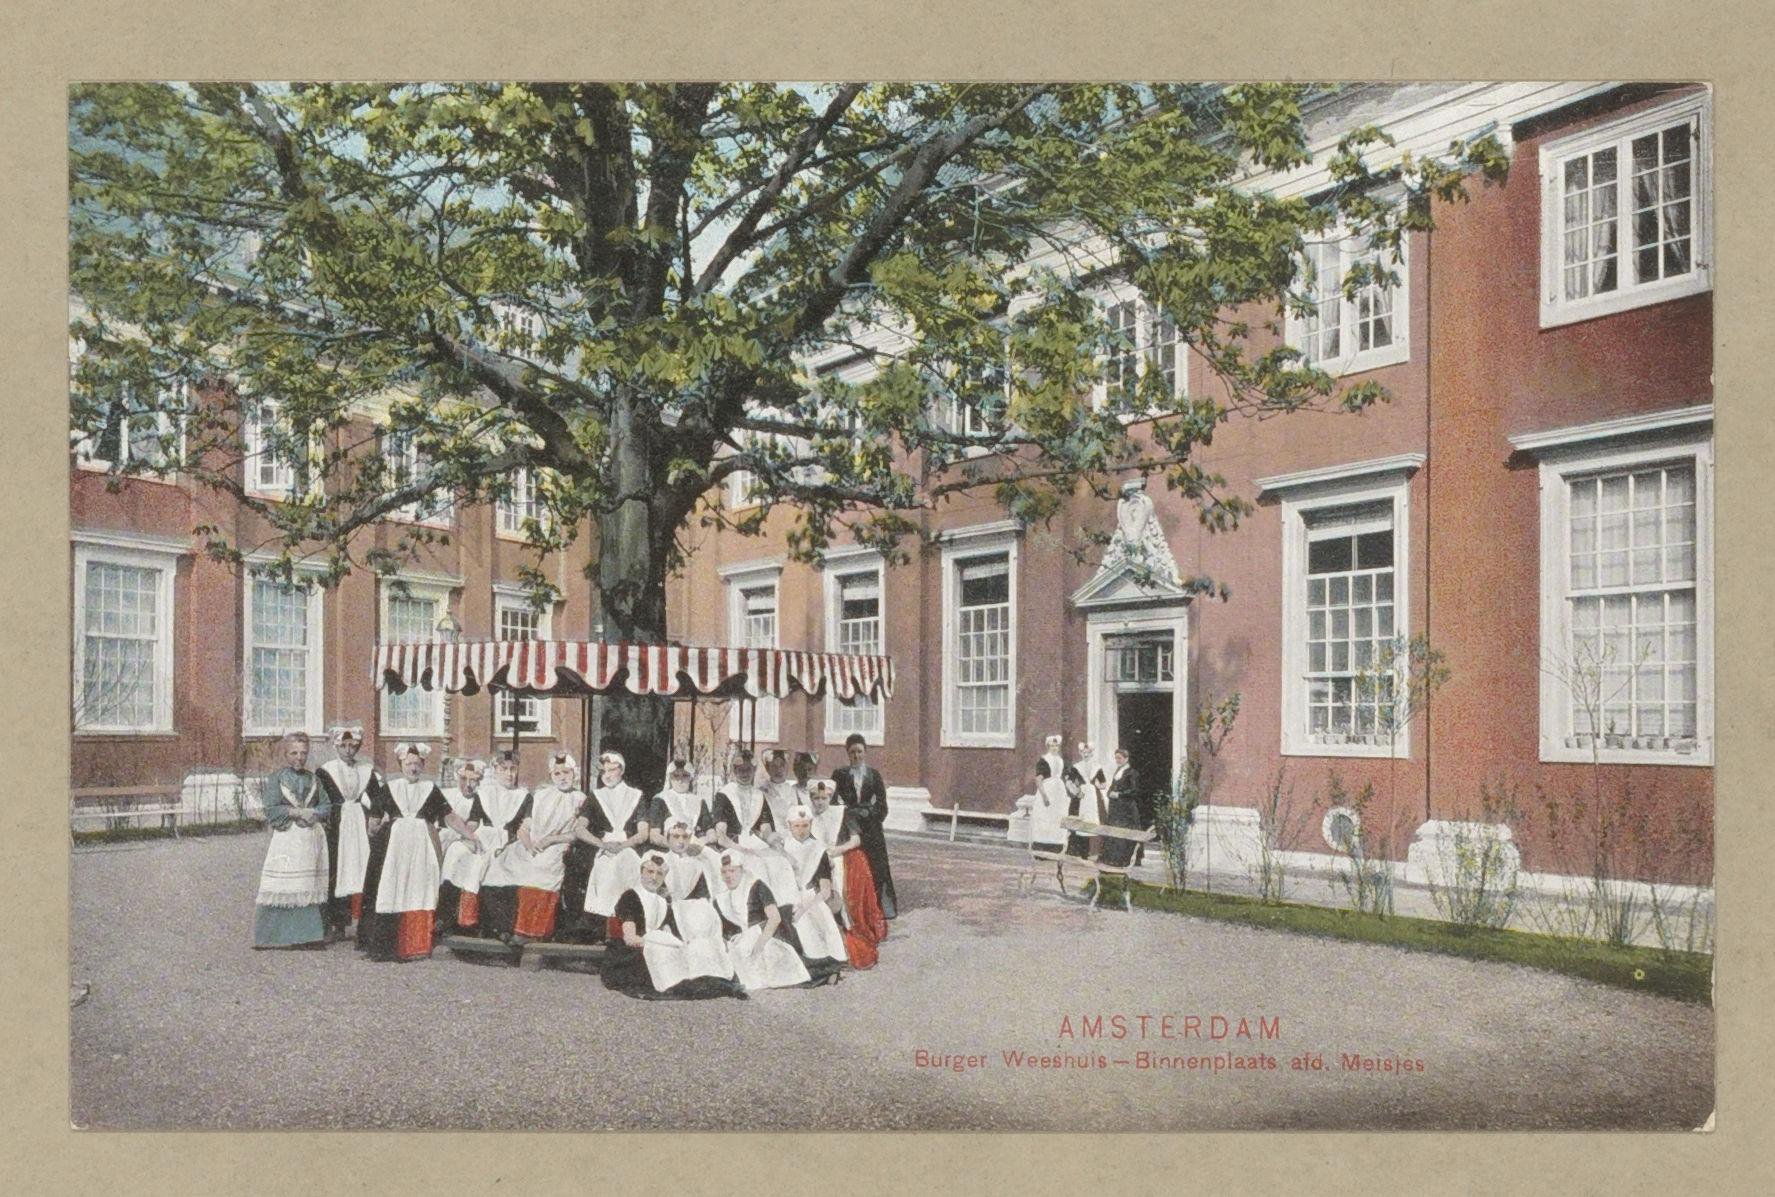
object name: photomechanical print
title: Binnenplaats van de meisjesafdeling van het Burgerweeshuis te Amsterdam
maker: Anonymous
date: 1890-1920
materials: cardboard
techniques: four-color autotype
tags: orphanage, orphans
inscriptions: collector's mark: Lugt 1641b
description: Onderwerpsrubriek binnen de Atlas Amsterdam: Armwezen en liefdadige instellingen: I. Stadsinrichtingen: Burgerweeshuis.